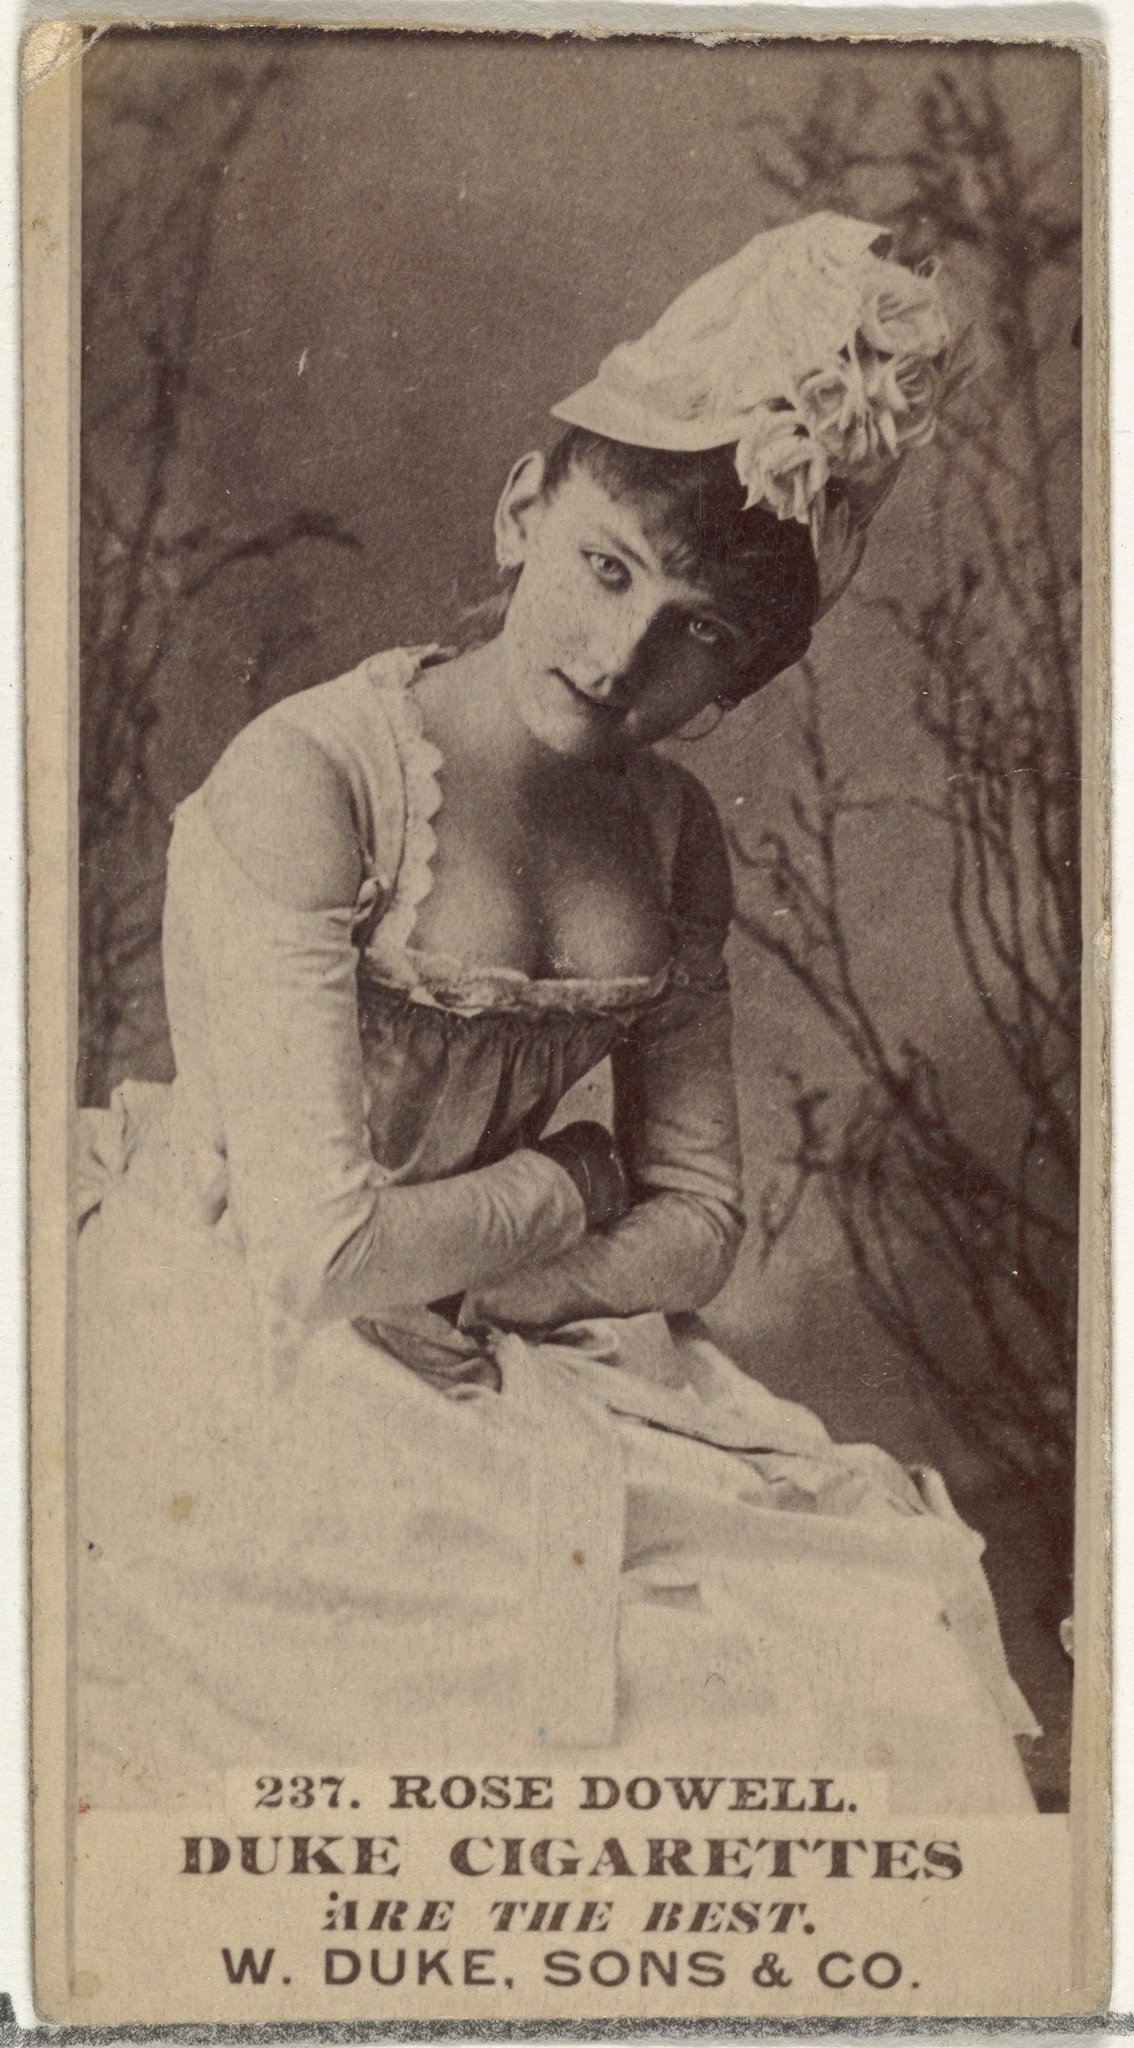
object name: photograph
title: Card Number 237, Rose Dowell, from the Actors and Actresses series (N145-6) issued by Duke Sons & Co. to promote Duke Cigarettes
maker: w. duke, sons & co.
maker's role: publisher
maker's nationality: american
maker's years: 1870-1920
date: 1880-1889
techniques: albumen silver print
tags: portraits,women,actresses